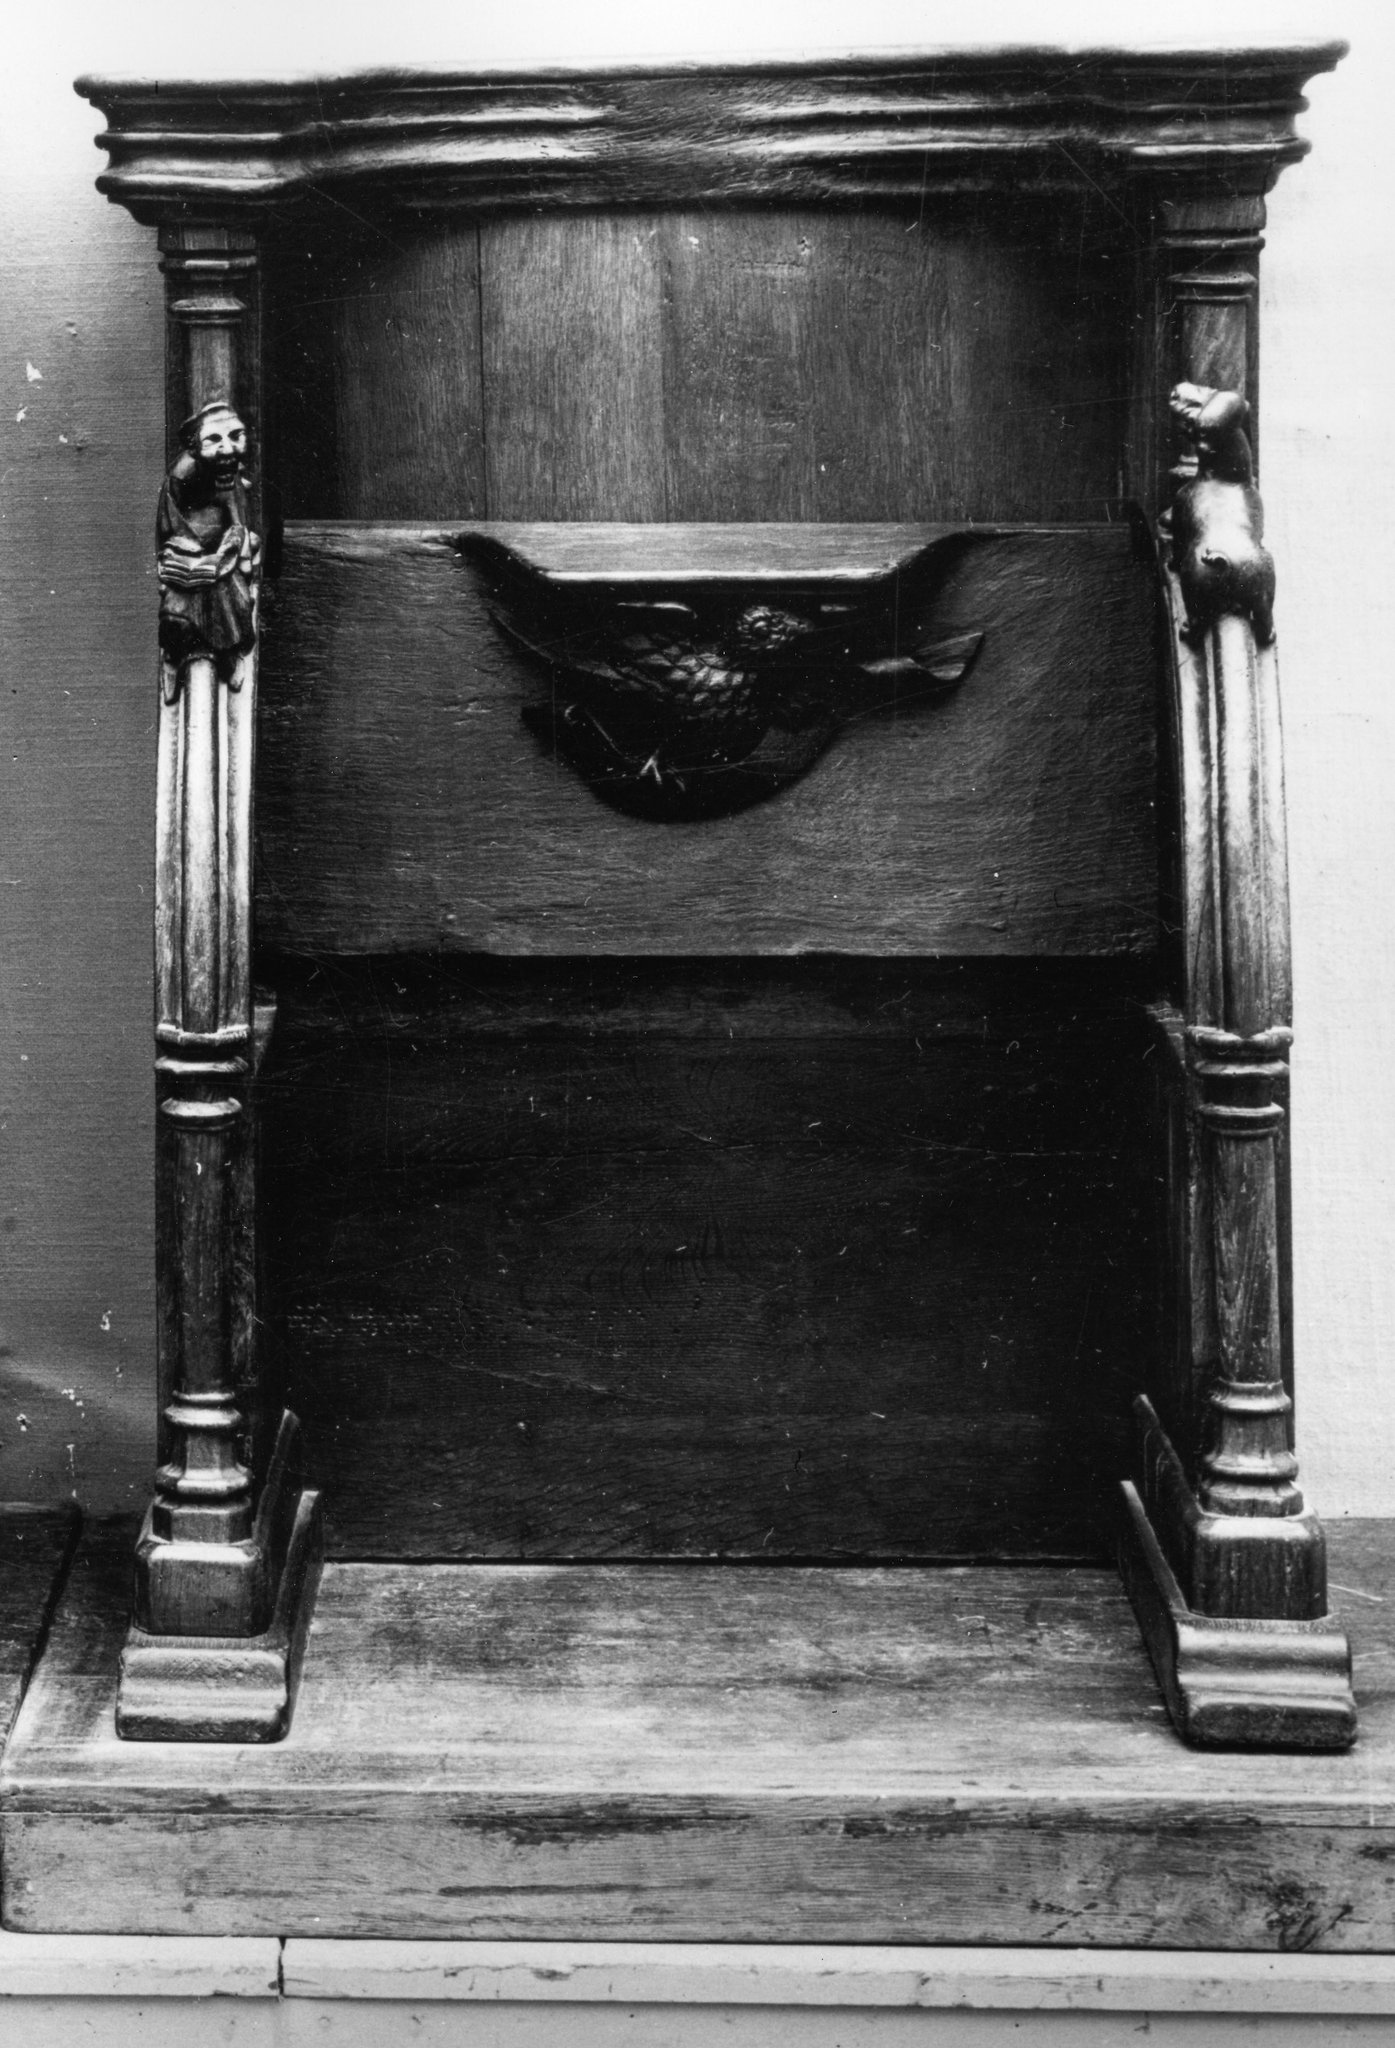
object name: choir stall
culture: french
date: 1401-1500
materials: wood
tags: birds